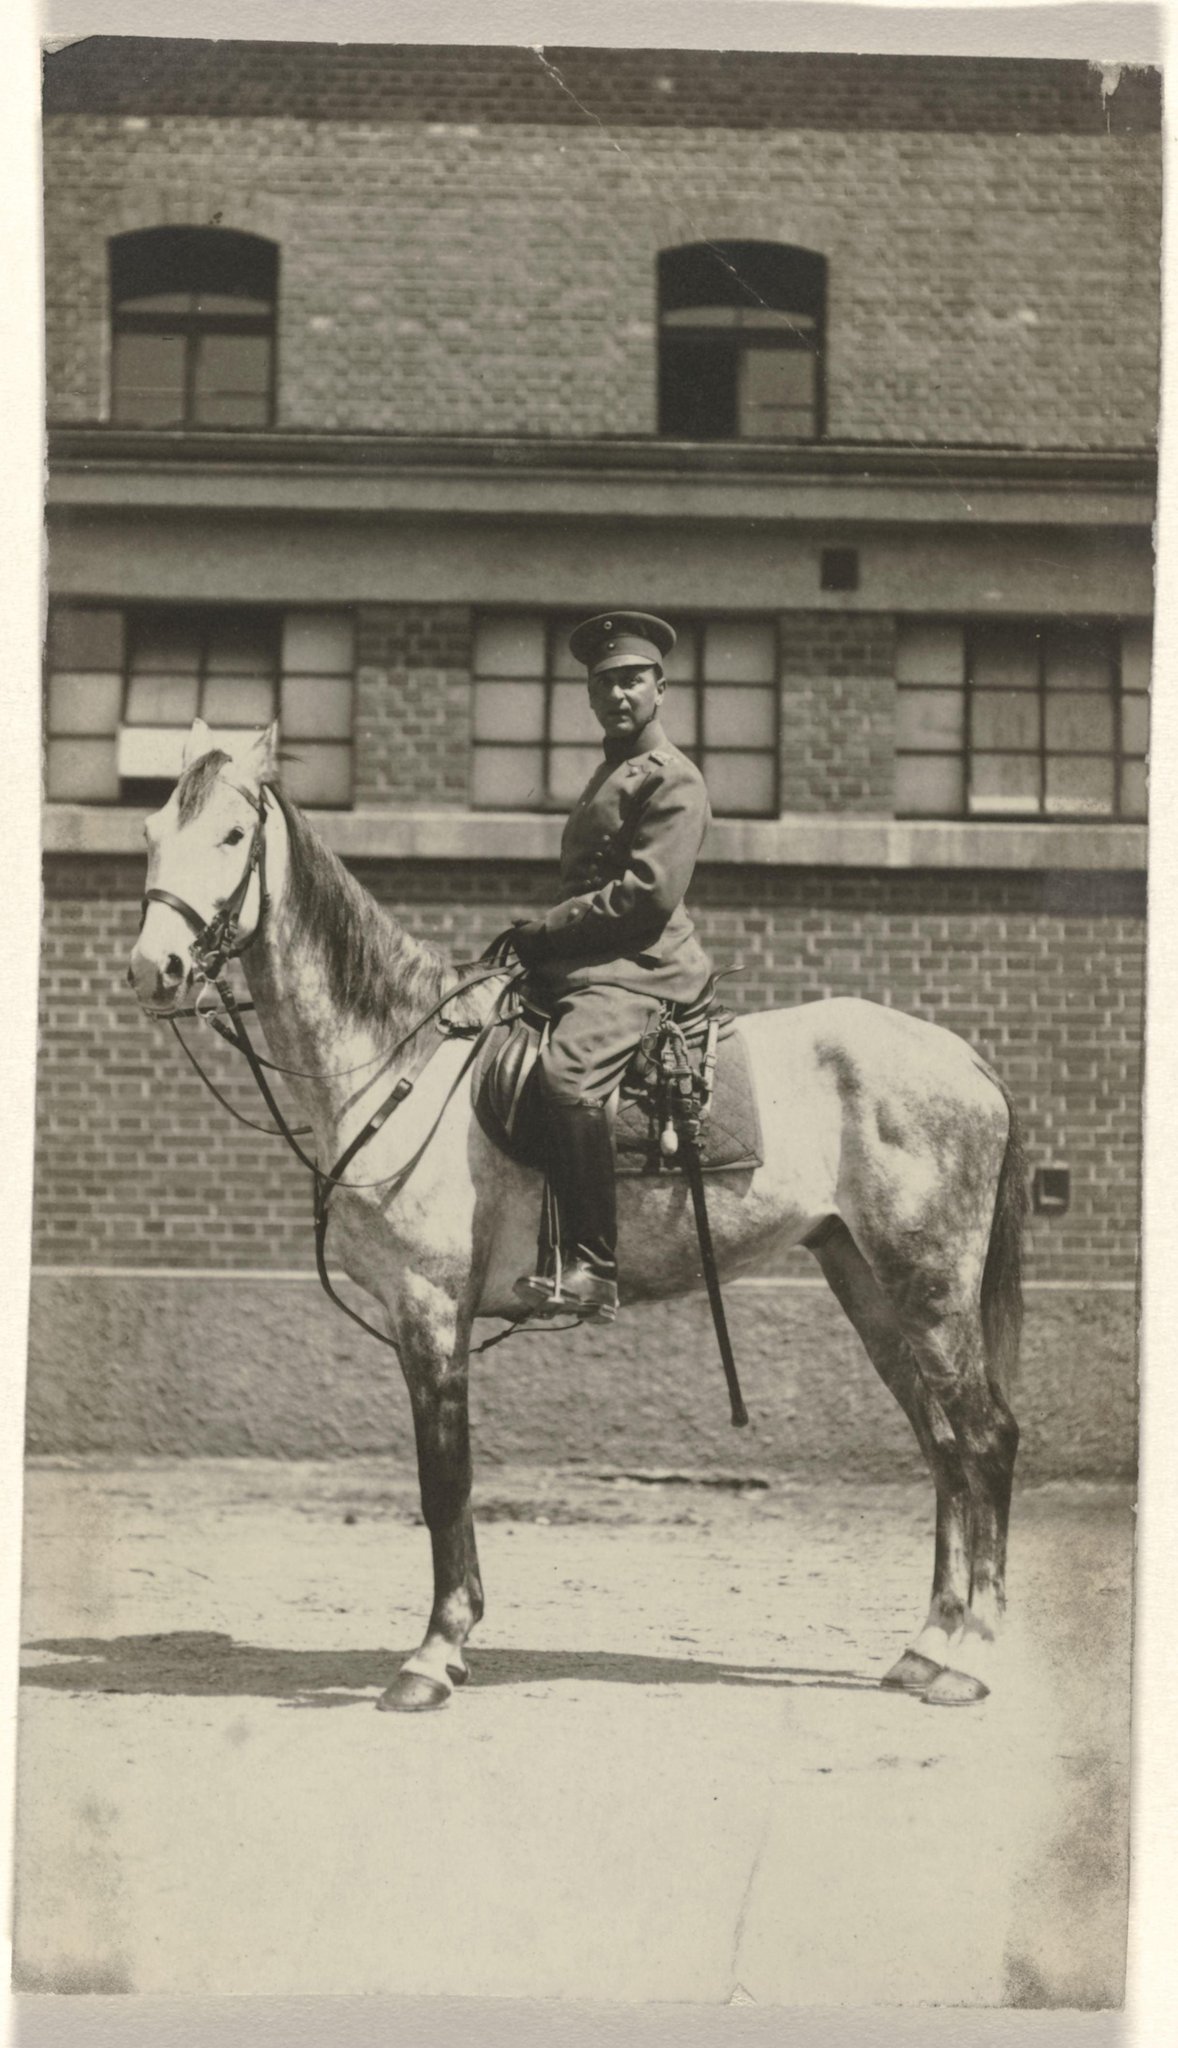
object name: photograph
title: Arthur Moos te paard in het uniform van het 20e regiment Uhlanen, mei 1916, in Ludwigsburg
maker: Anonymous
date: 1905-1916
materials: photographic support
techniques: gelatin silver print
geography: ludwigsburg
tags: arthur moos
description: Arthur Moos te paard in het uniform van het 20e regiment Uhlanen in Ludwigsburg.